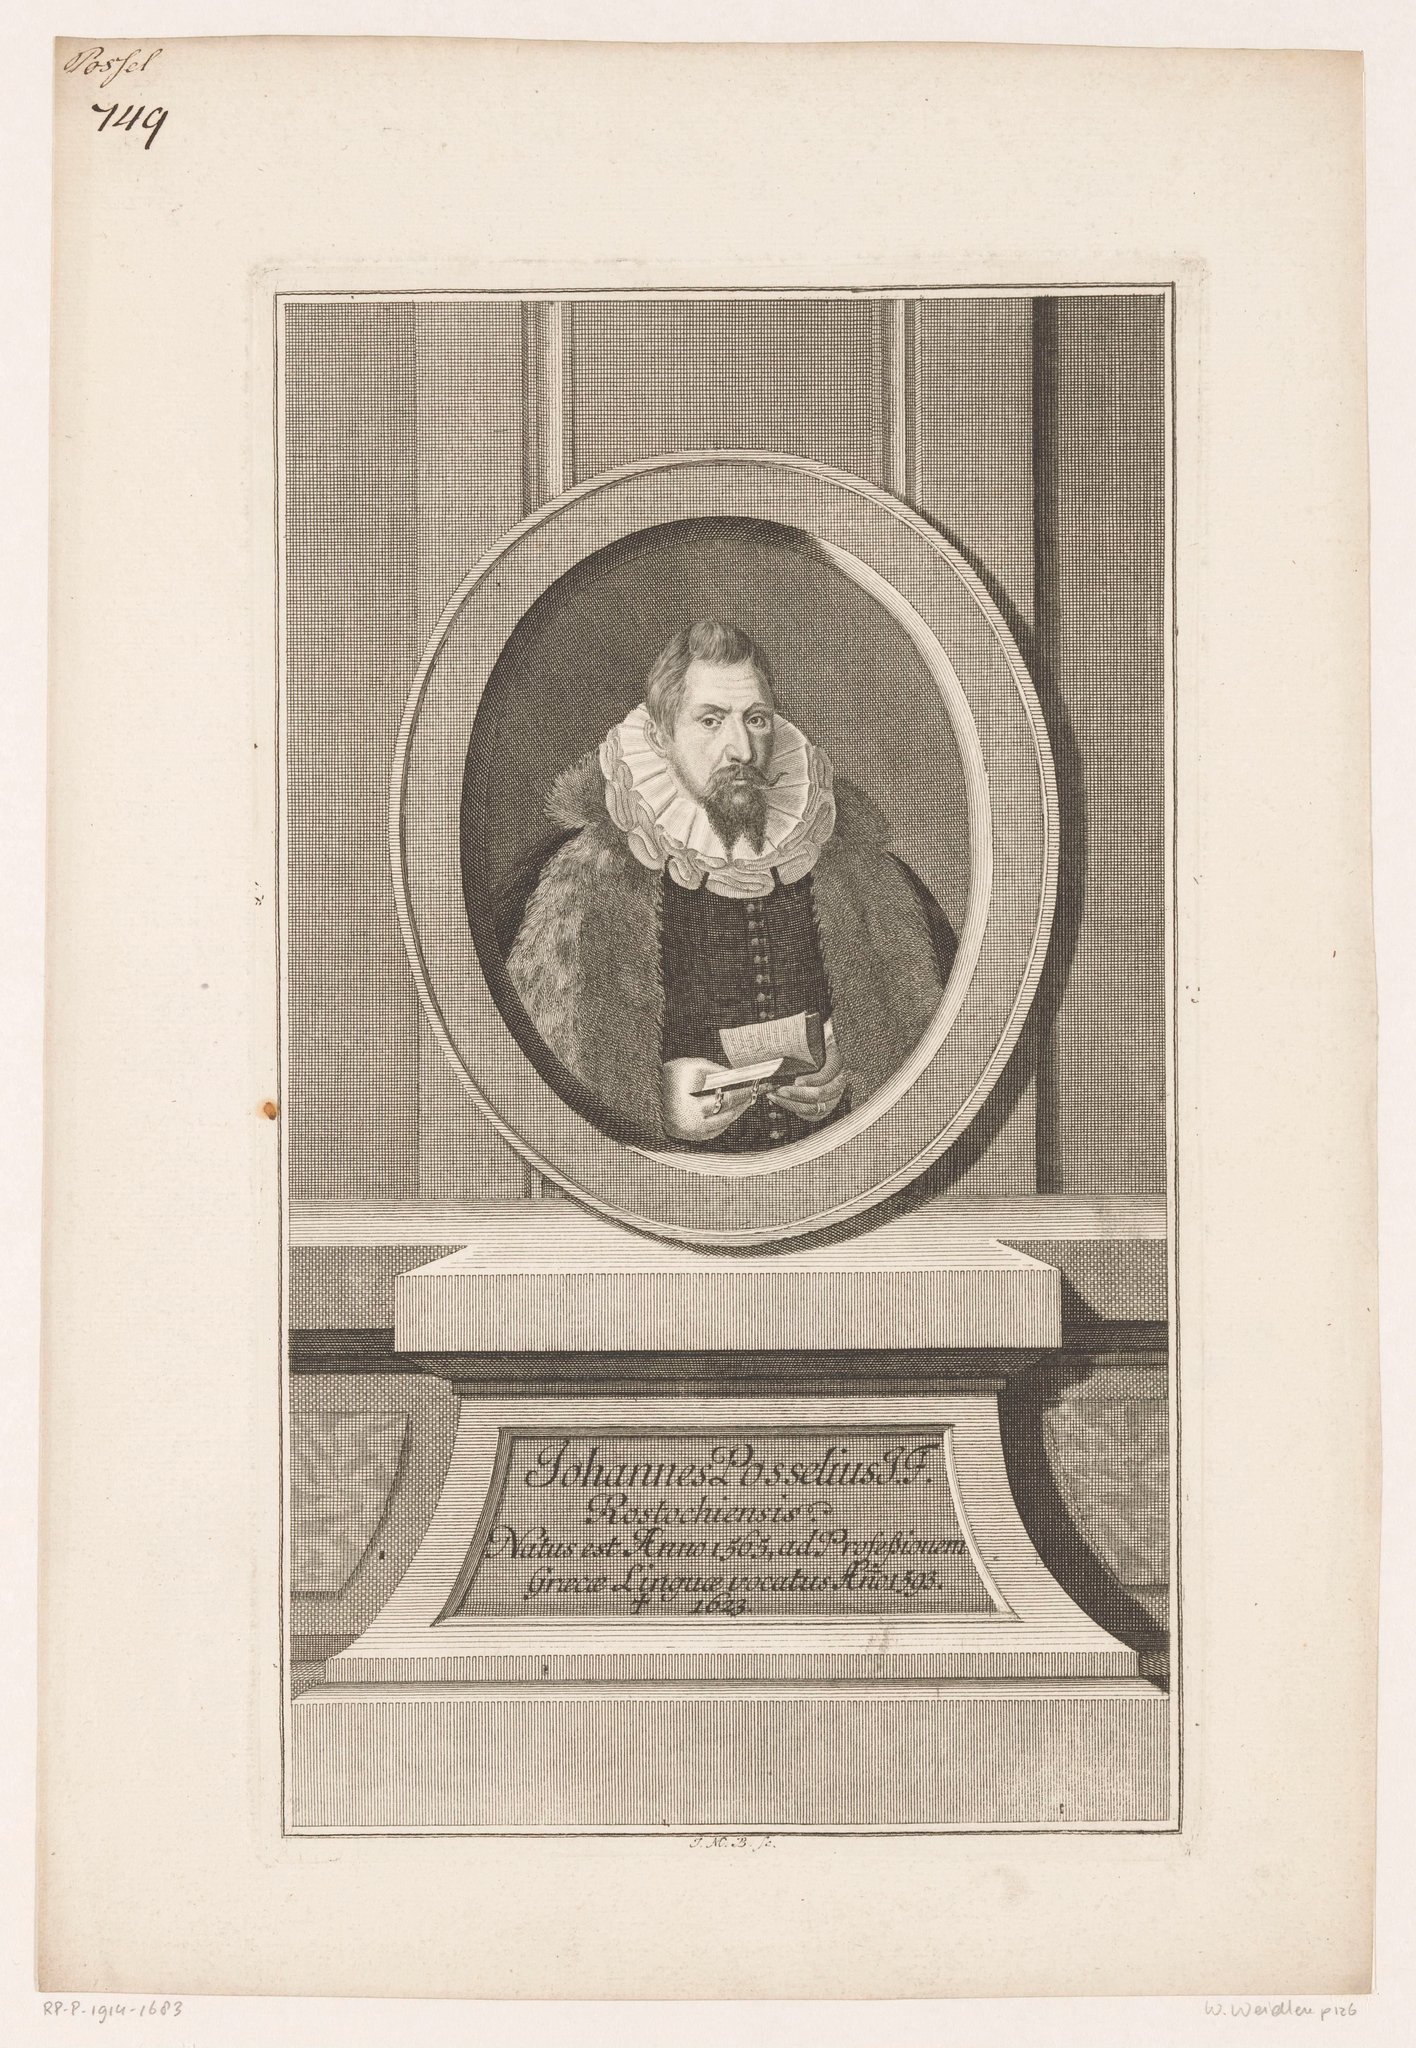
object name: print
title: Portret van Johann Posselius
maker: johann martin bernigeroth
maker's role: print maker, publisher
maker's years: 1713-1767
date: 1743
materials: paper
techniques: engraving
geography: leipzig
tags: historical persons, book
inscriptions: collector's mark: Lugt 2228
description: Een andere staat van deze prent is gebruikt in: Westphalen, Ernst Joachim von. Monumenta Inedita Rerum Germanicarum Praecipue Cimbricarum Et Megapolensium (...). 4 dln. Leipzig: Johann Christian Martini, 1739-1745, dl. 3 (1743), na p. 1204.